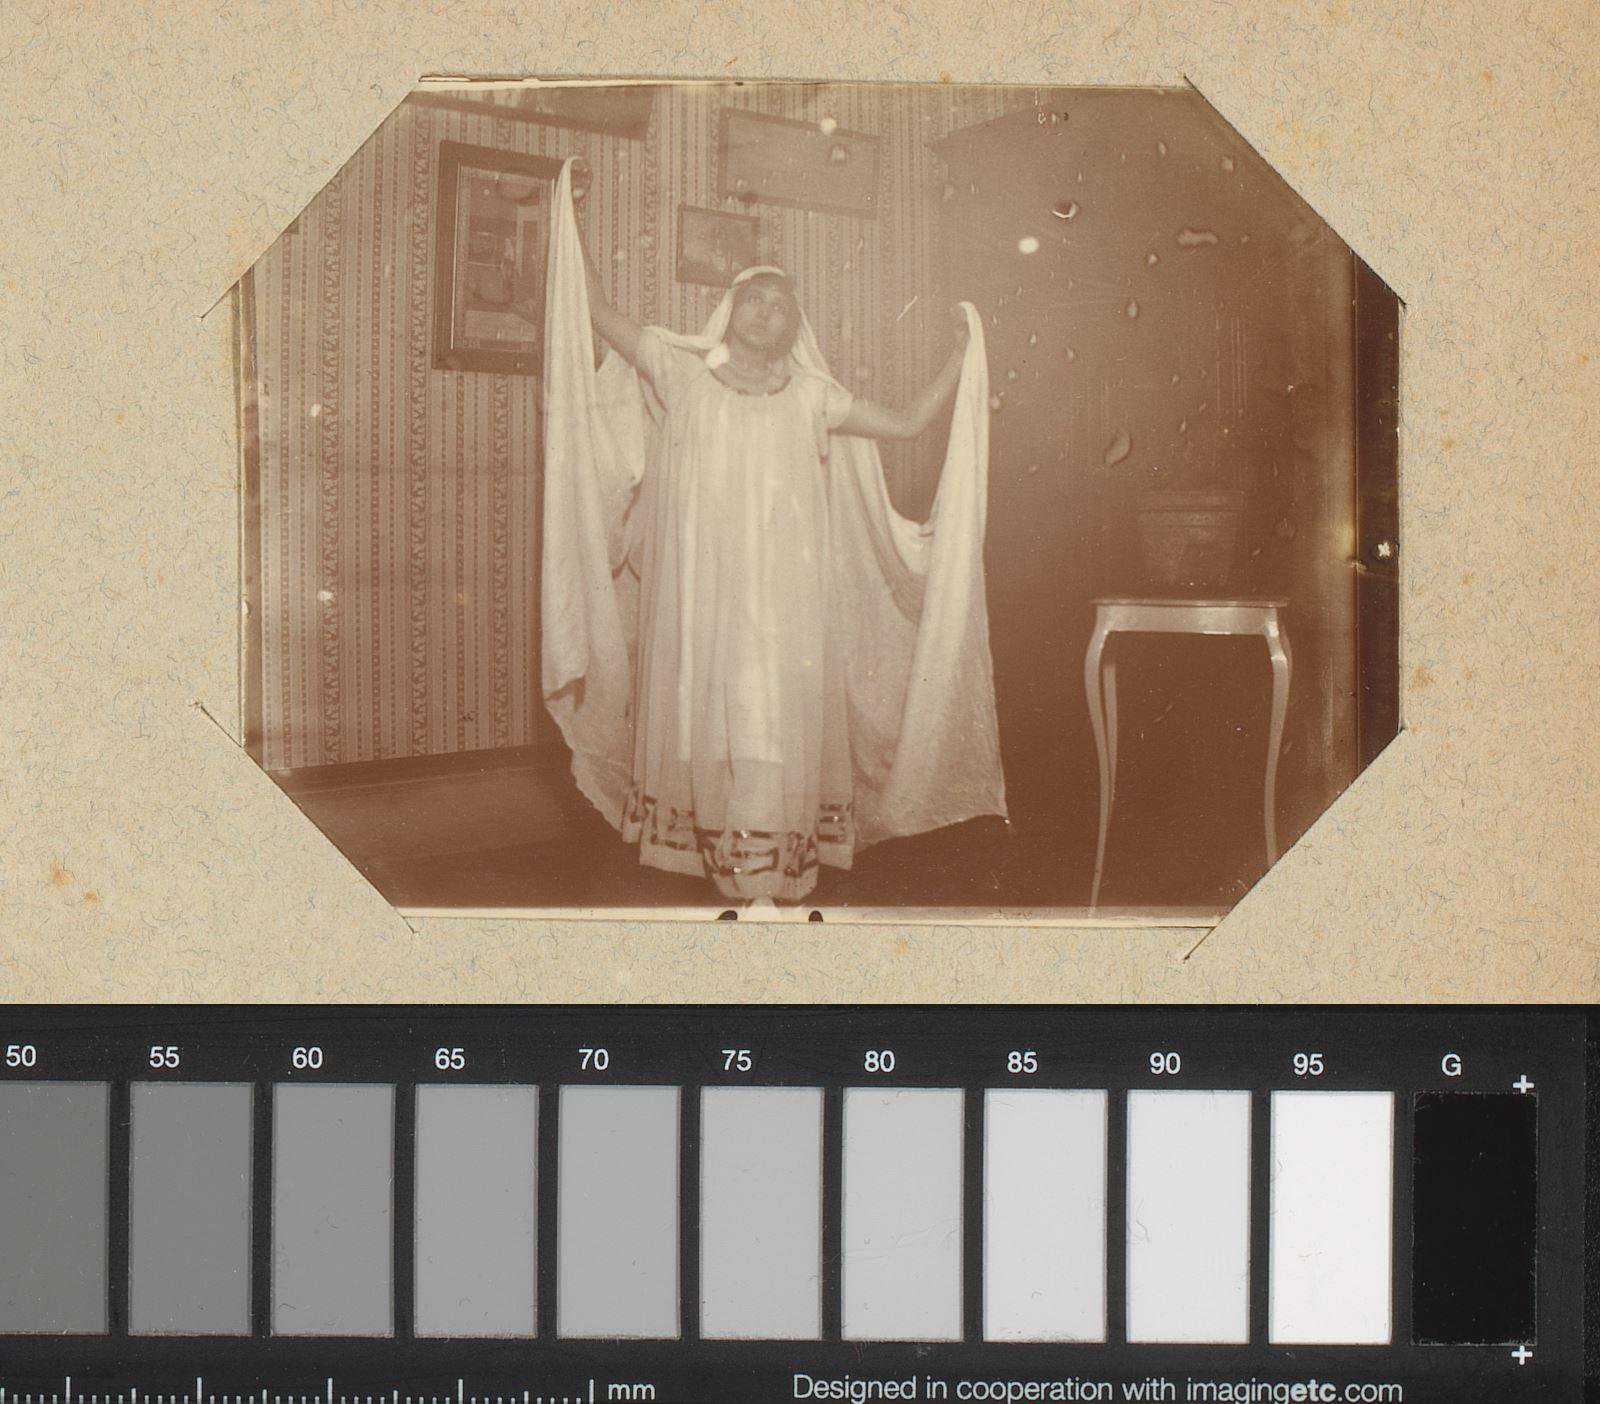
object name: album leaf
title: Portret van een vrouw in verkleedkleding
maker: Anonymous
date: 1897-1900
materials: paper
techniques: gelatin silver print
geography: france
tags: adult woman, historical persons, historical costume, france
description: Over de foto is een ander negatief afgedrukt van een voorstelling van bomen.